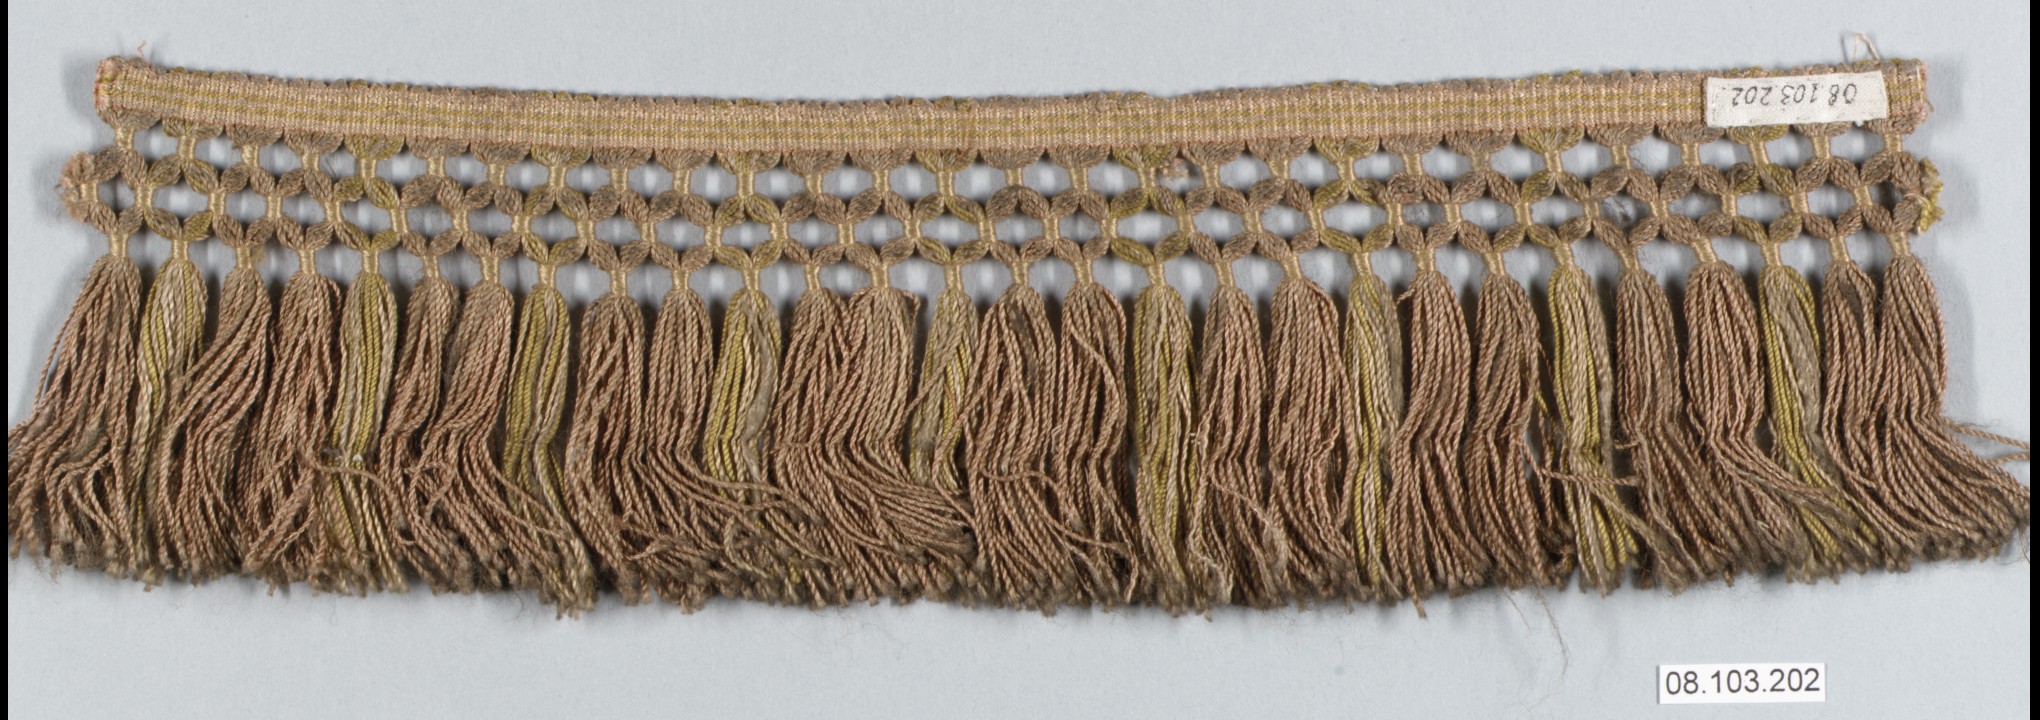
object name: fringe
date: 1701-1900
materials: silk